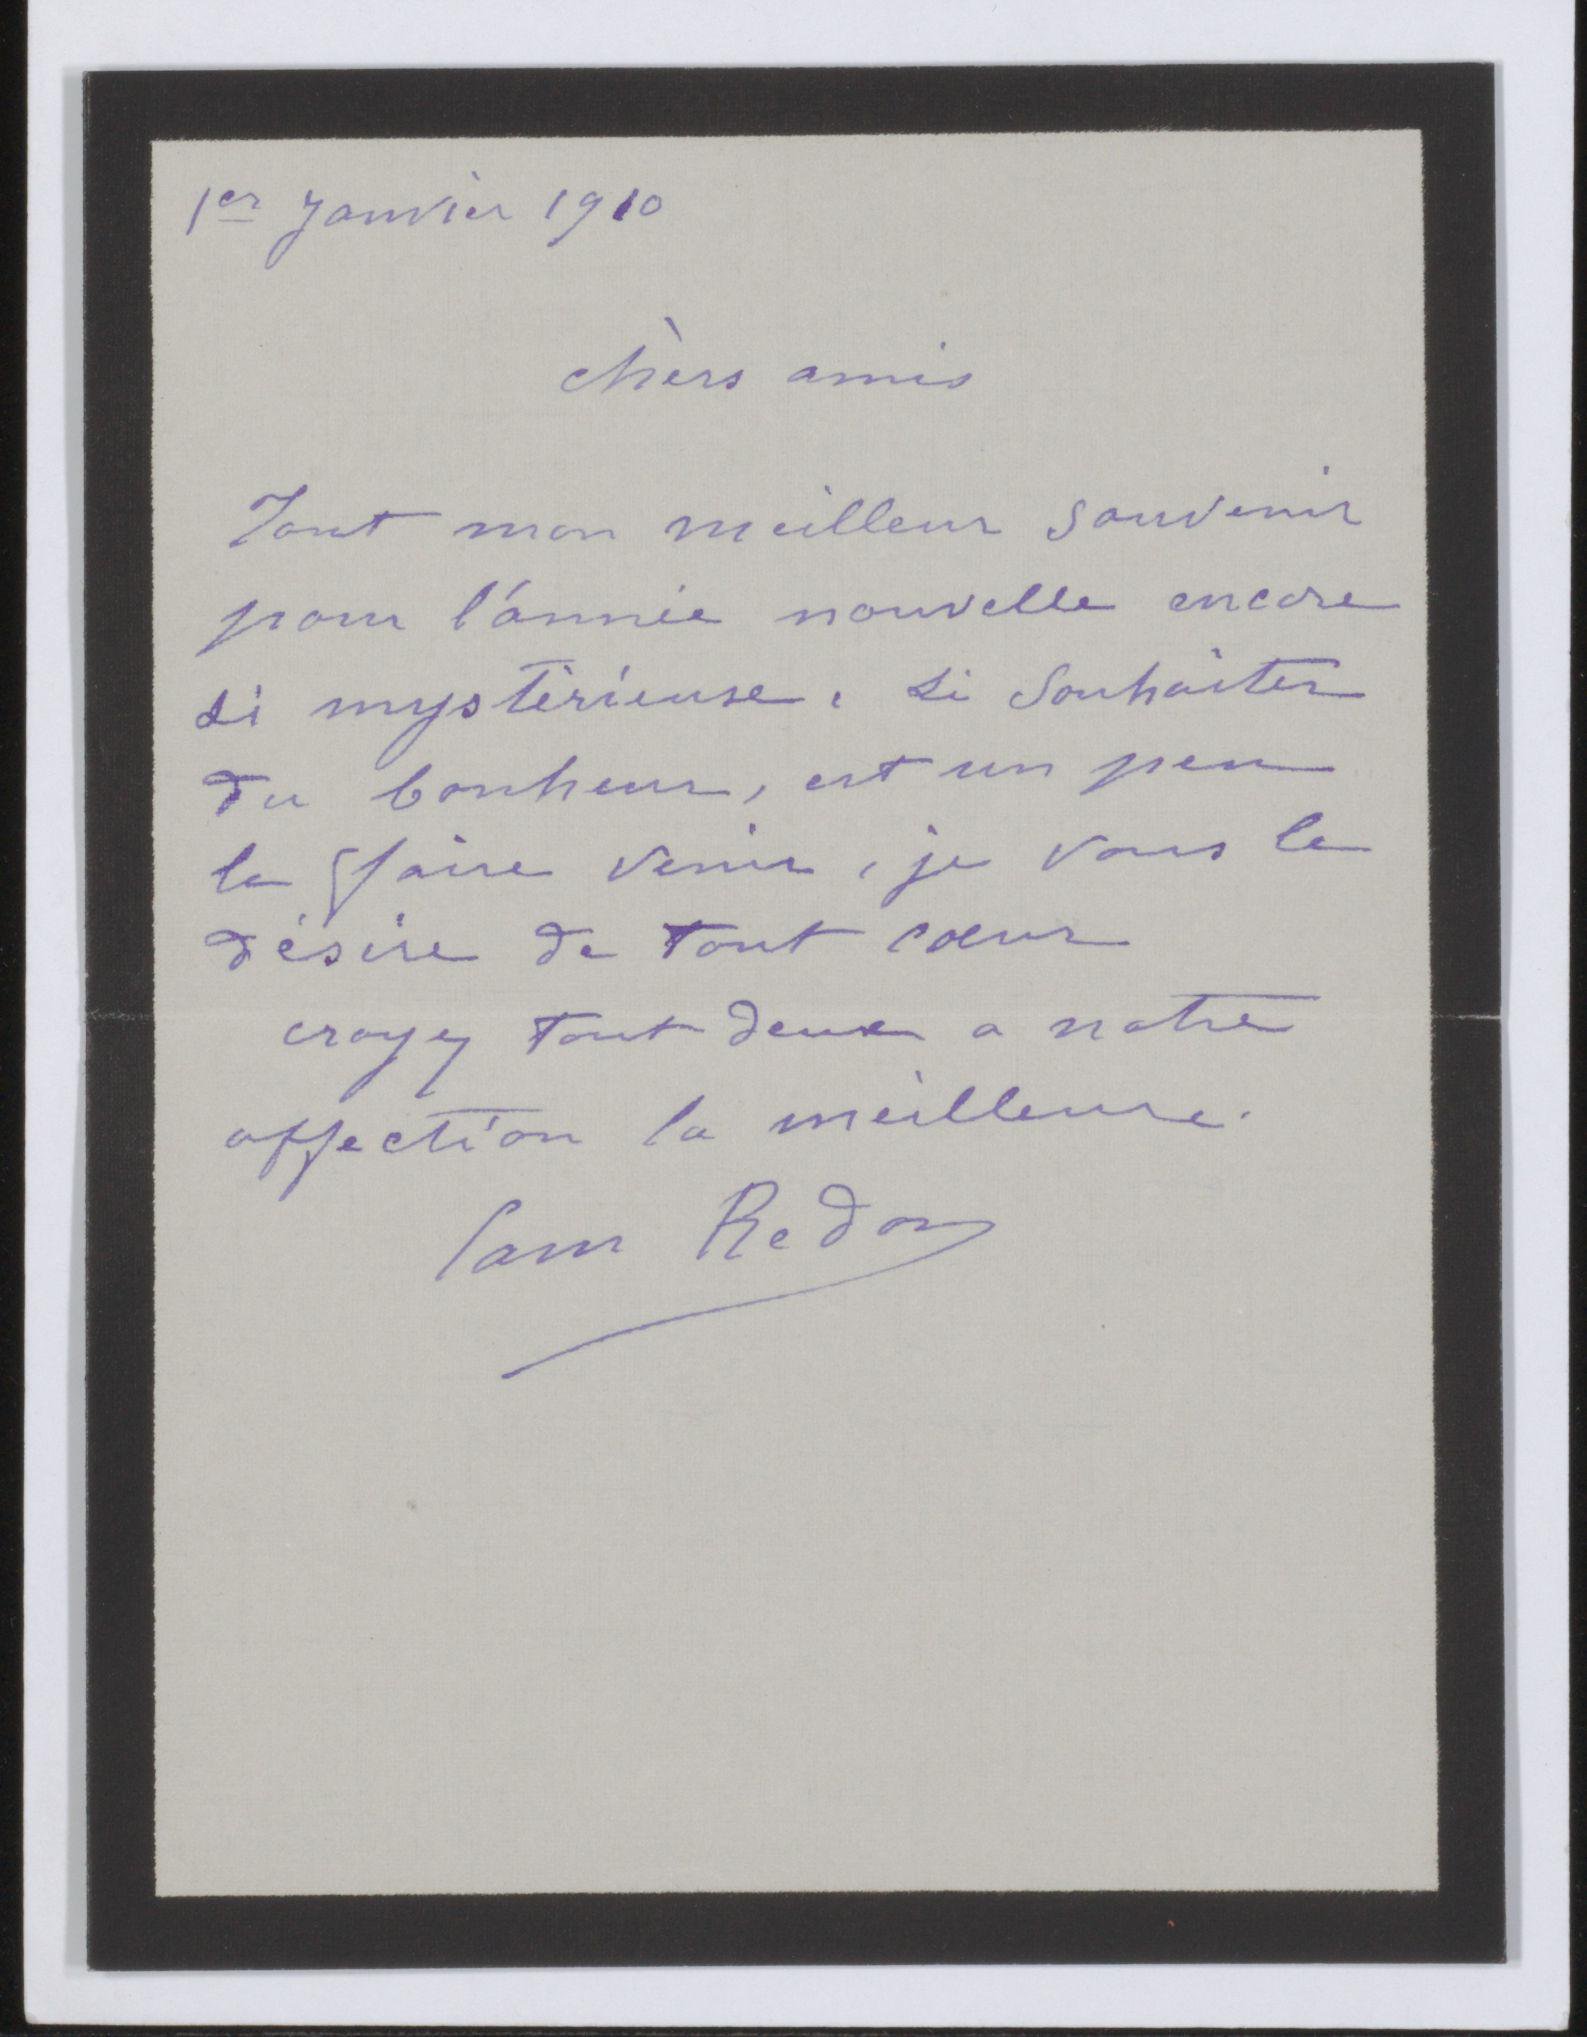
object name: letter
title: Brief aan Andries Bonger en Anne Marie Louise van der Linden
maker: camille redon-falte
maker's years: 1853-1923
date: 1910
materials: ink, paper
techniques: pen, writing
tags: amsterdam, andries bonger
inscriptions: watermark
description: Brief behoort tot een album samengesteld door weduwe Françoise W.M. Barones van der Borch van Verwolde met afschriften van brieven met betrekking tot (de familie van) Odilon Redon. De brief werd bewaard op pagina 162.